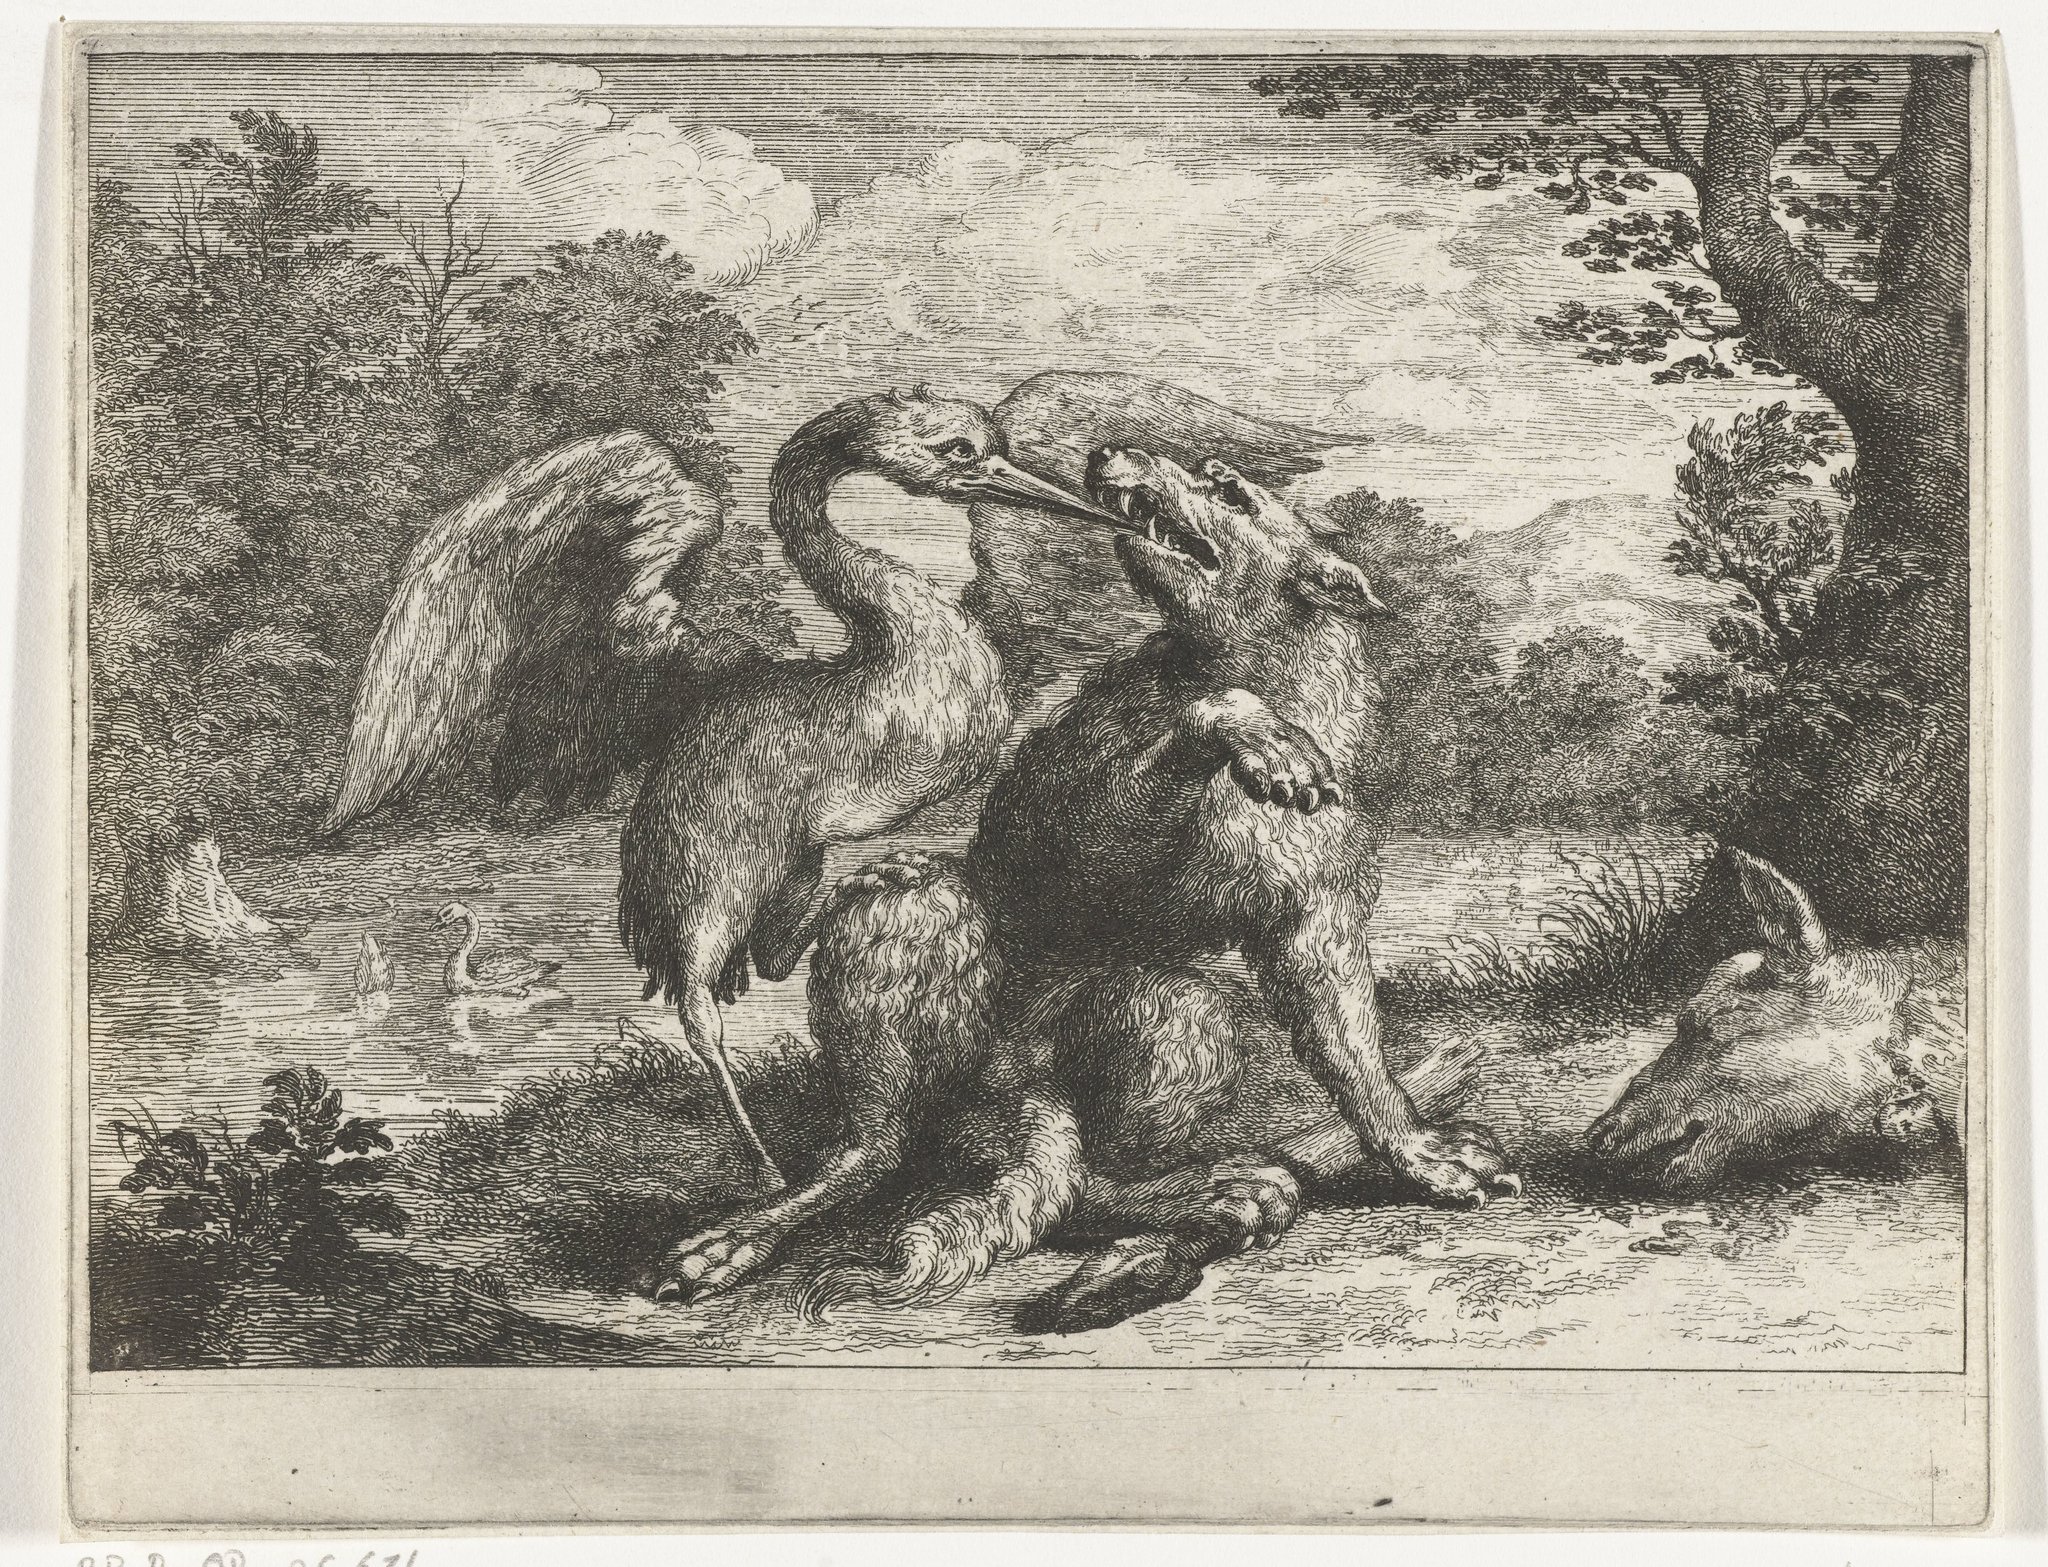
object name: print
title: Wolf en kraanvogel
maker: abraham bloteling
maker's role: draughtsman, print maker, publisher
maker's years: 1640-1690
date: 1655-1690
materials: paper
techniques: etching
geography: amsterdam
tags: shore-birds and wading-birds: crane, fables of aesop : use 85(...), beasts of prey, predatory animals: wolf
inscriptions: collector's mark: Lugt 240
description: Een kraanvogel haalt met zijn snavel een botje uit de hals van een wolf. De wolf had een schaap buit gemaakt en bij het opeten ervan was een botje in zijn hals blijven steken. Deze voorstelling illustreert een verhaal uit de fabelen van Aesopus.